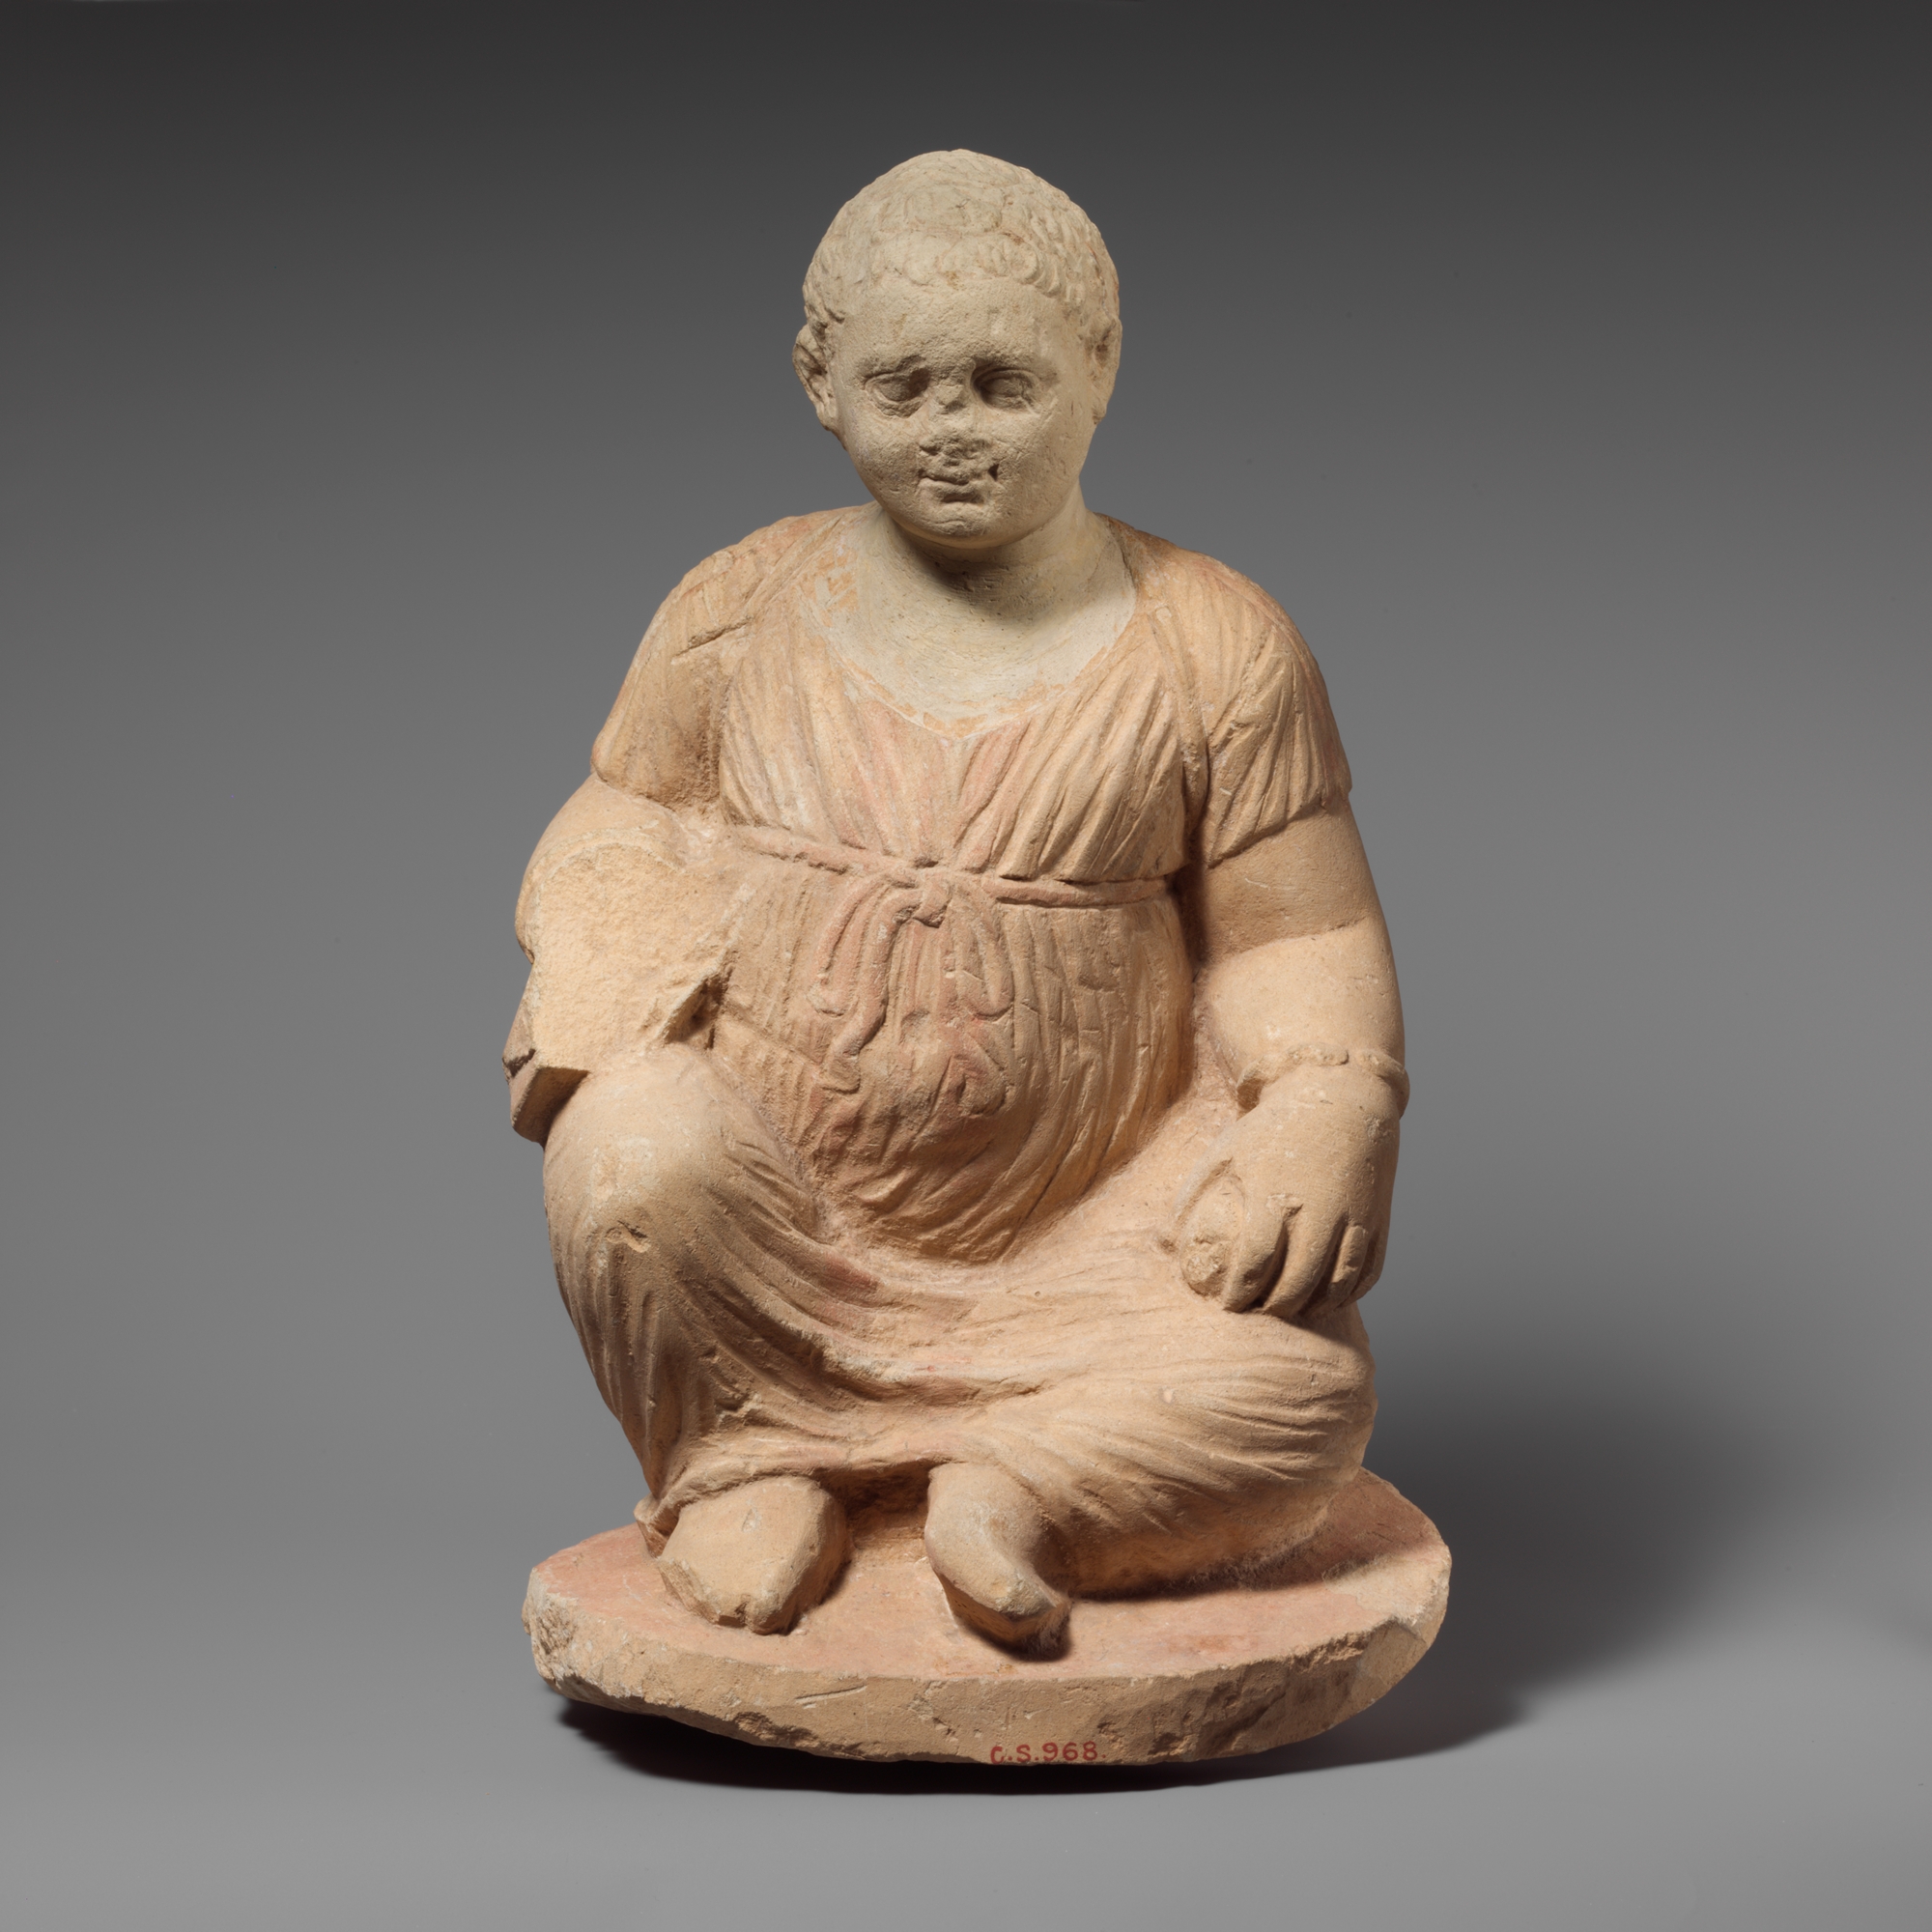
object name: statuette of a temple boy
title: Limestone statuette of a temple girl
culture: cypriot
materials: limestone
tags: girls